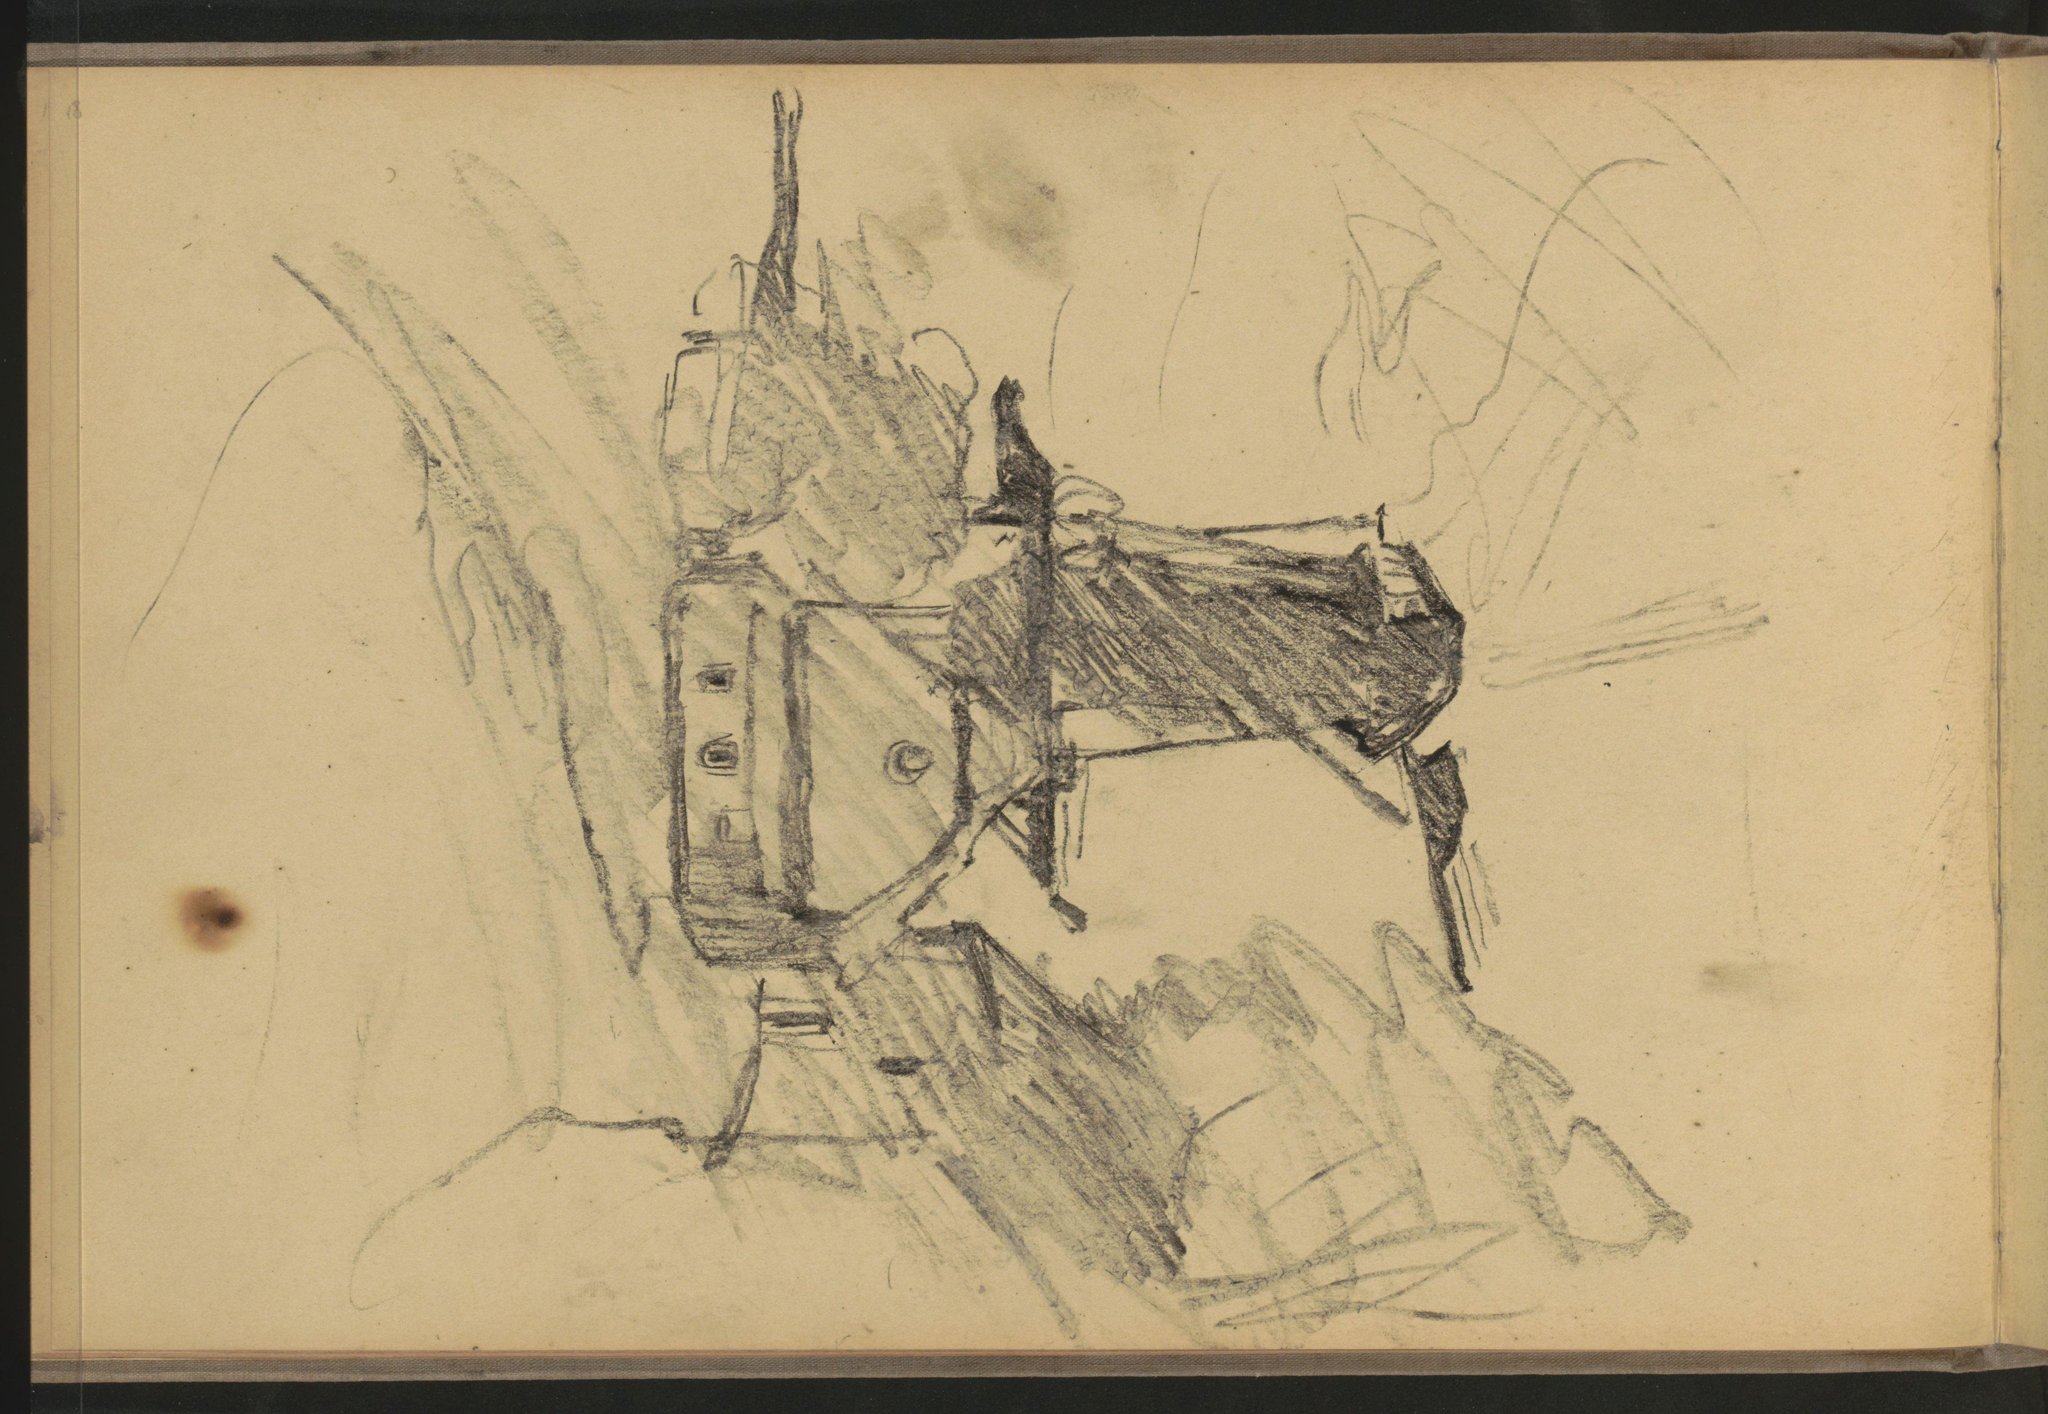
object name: sketchbook leaf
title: Gezicht op de molen Rijn en Lek te Wijk bij Duurstede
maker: willem witsen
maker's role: draughtsman, painter, print maker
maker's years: 1860-1923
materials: chalk, paper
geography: wijk bij duurstede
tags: urban housing, windmill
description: Voorstudie voor de ets 'Korenmolen, Wijk bij Duurstede', ca. 1908.